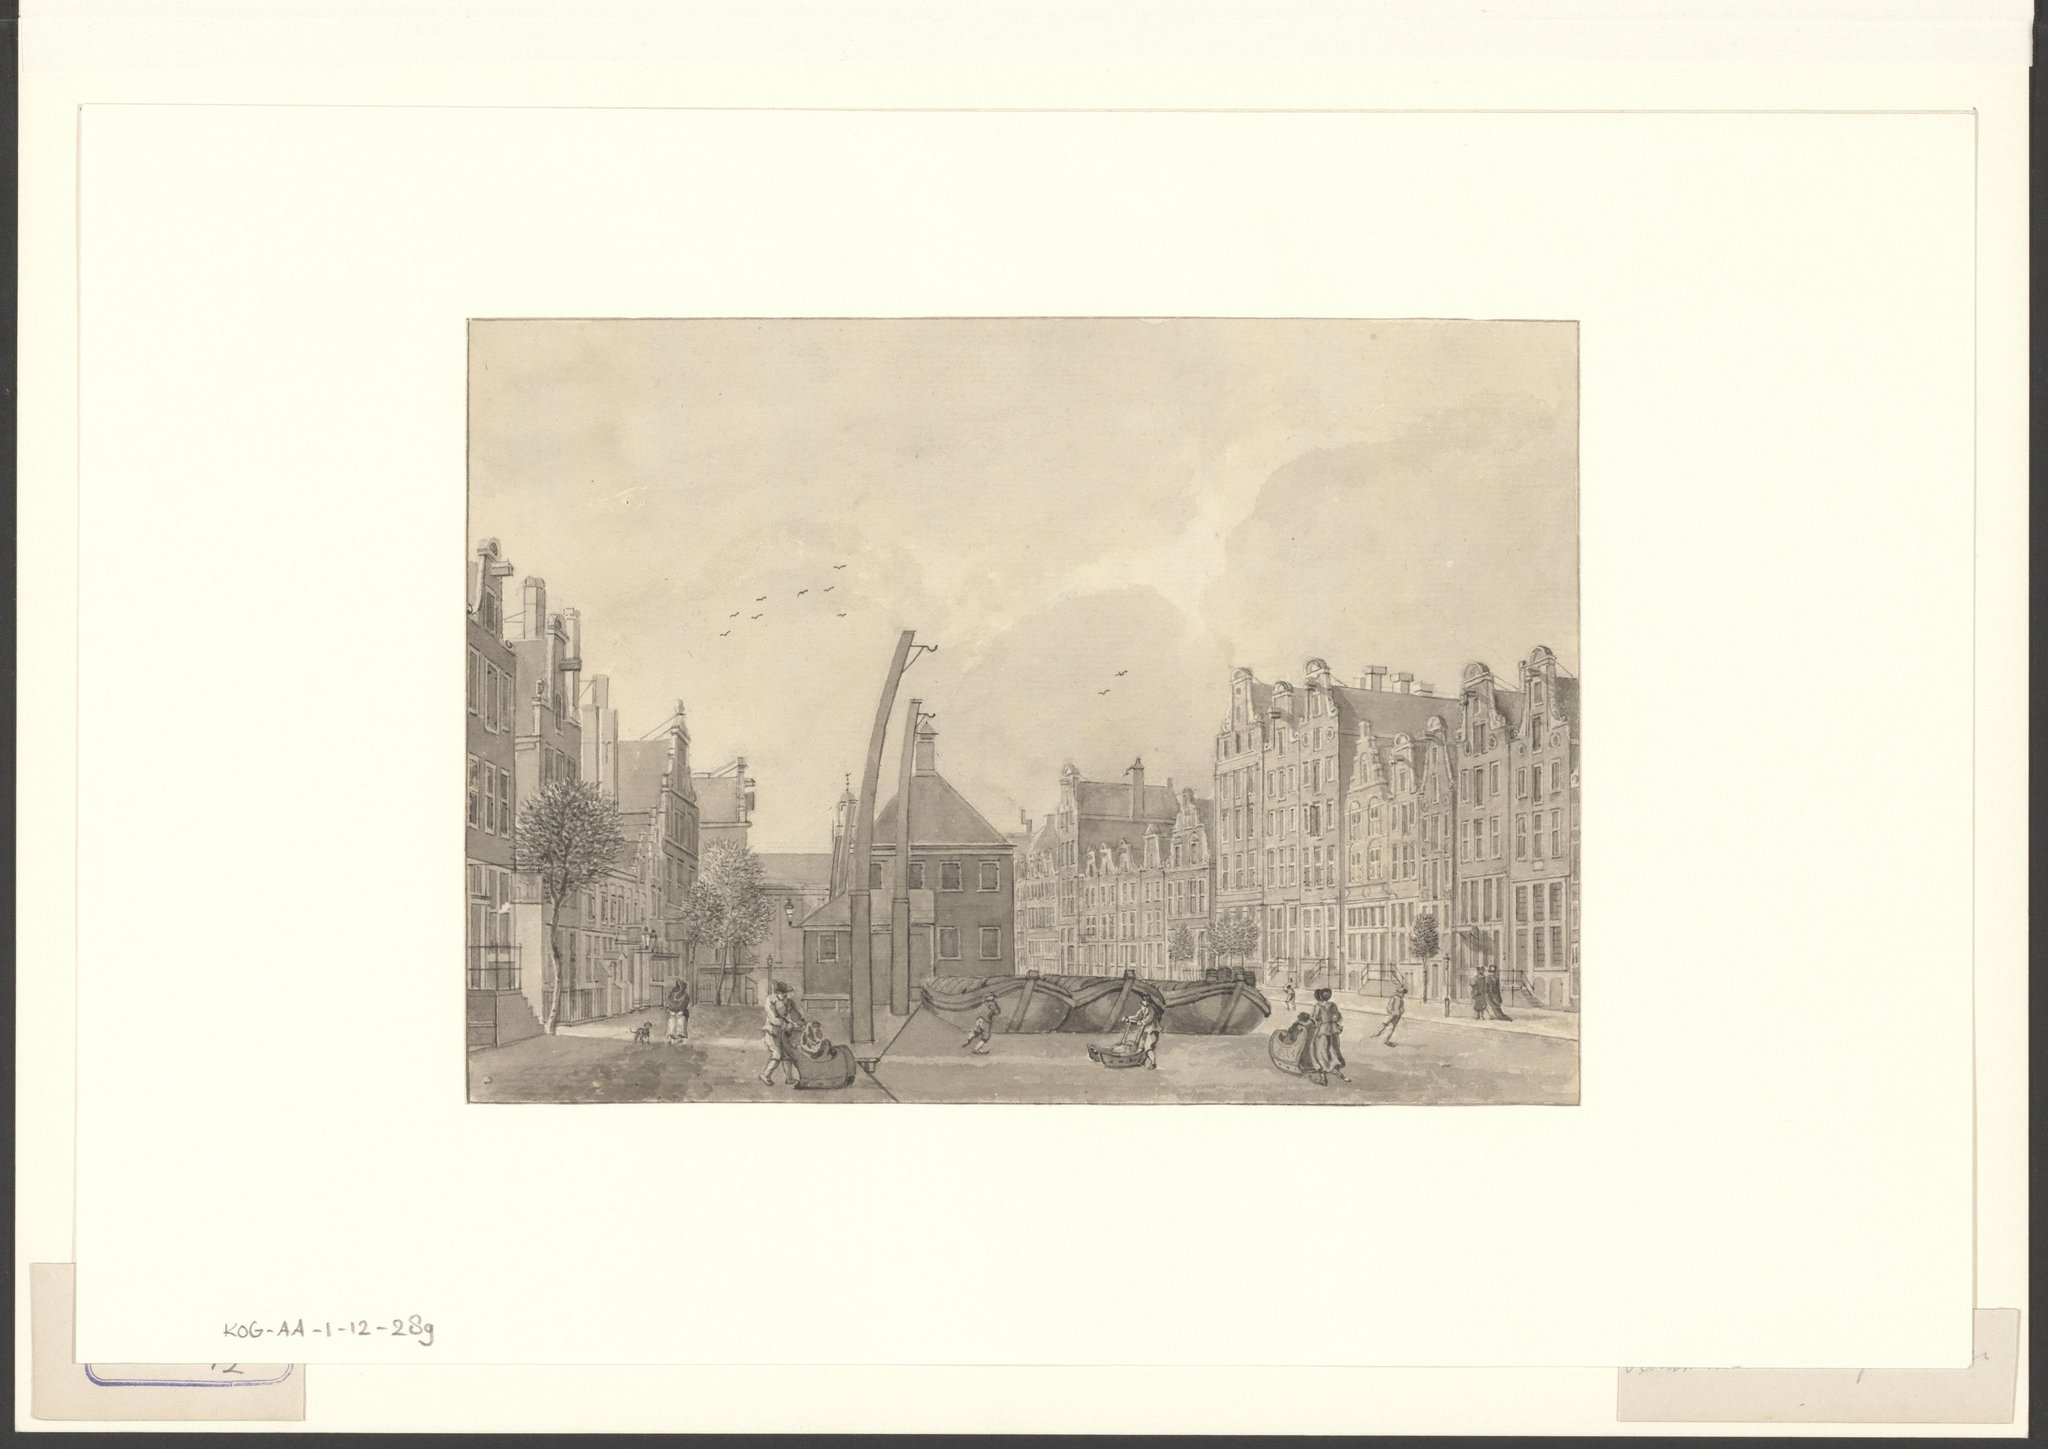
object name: drawing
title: Gezicht op schaatsers op het Rokin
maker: hermanus petrus schouten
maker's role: draughtsman, painter, print maker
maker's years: 1747-1822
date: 1756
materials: ink, paper, pencil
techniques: brush, pen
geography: amsterdam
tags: city-view in general; 'veduta', canal, winter landscape; landscape symbolizing winter (the four seasons of the year), street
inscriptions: inscription: ‘Rokkin met t haagse rotterdamse en delftse veer / tot amsterdam 1756’, inscription: ‘Port. 12-289’, collector's mark: ‘12’ Lugt 1641b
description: Onderwerpsrubriek binnen de Atlas Amsterdam: Rokin, Rotterdammersloot, Rozengang, Rozengracht, Rozenstraat, Rusland, Rustenburgerstraat, Ruysdaelkade, Ruysdaelstraat, Ruyterkade (de), Ruyterweg (Admiraal de).